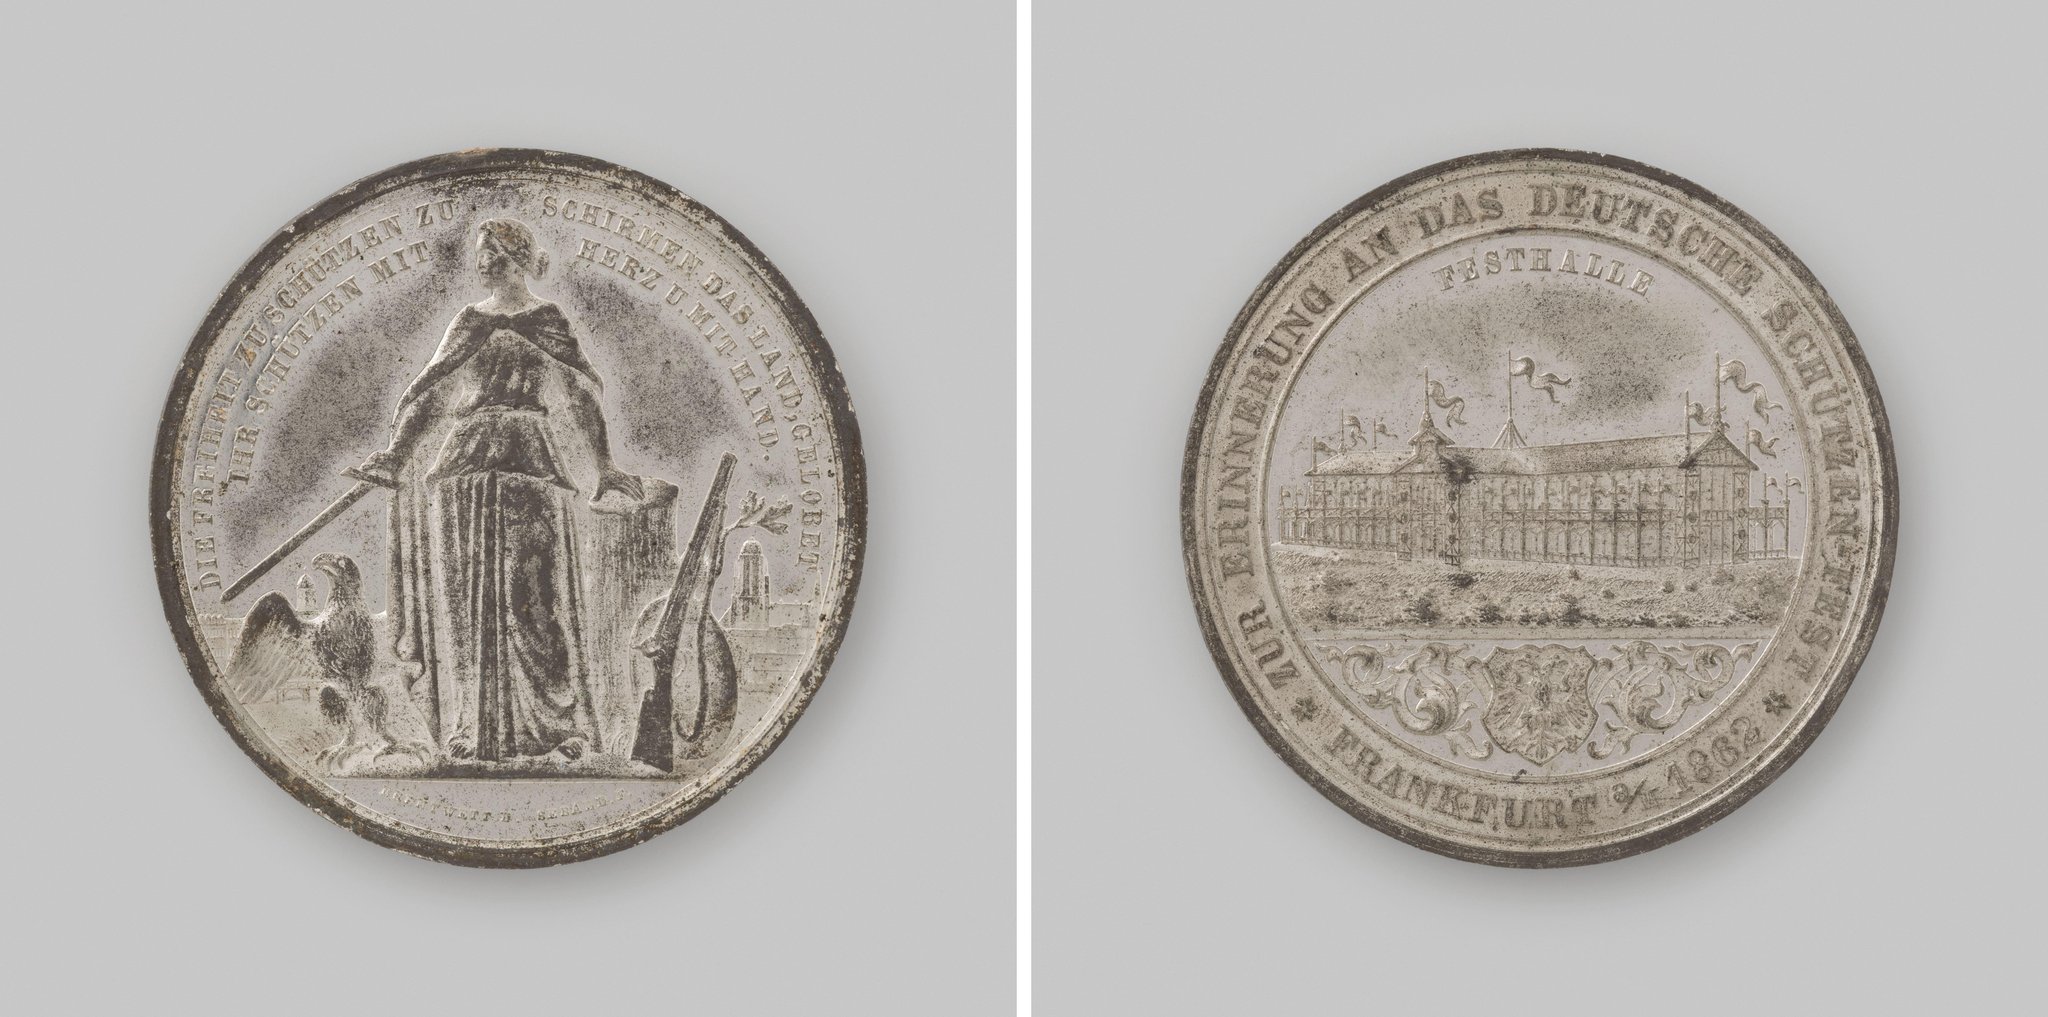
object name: marksman medal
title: Deutsche Schutzenfest te Frankfurt am Main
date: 1862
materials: silver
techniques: striking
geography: augsburg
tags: frankfurt am main